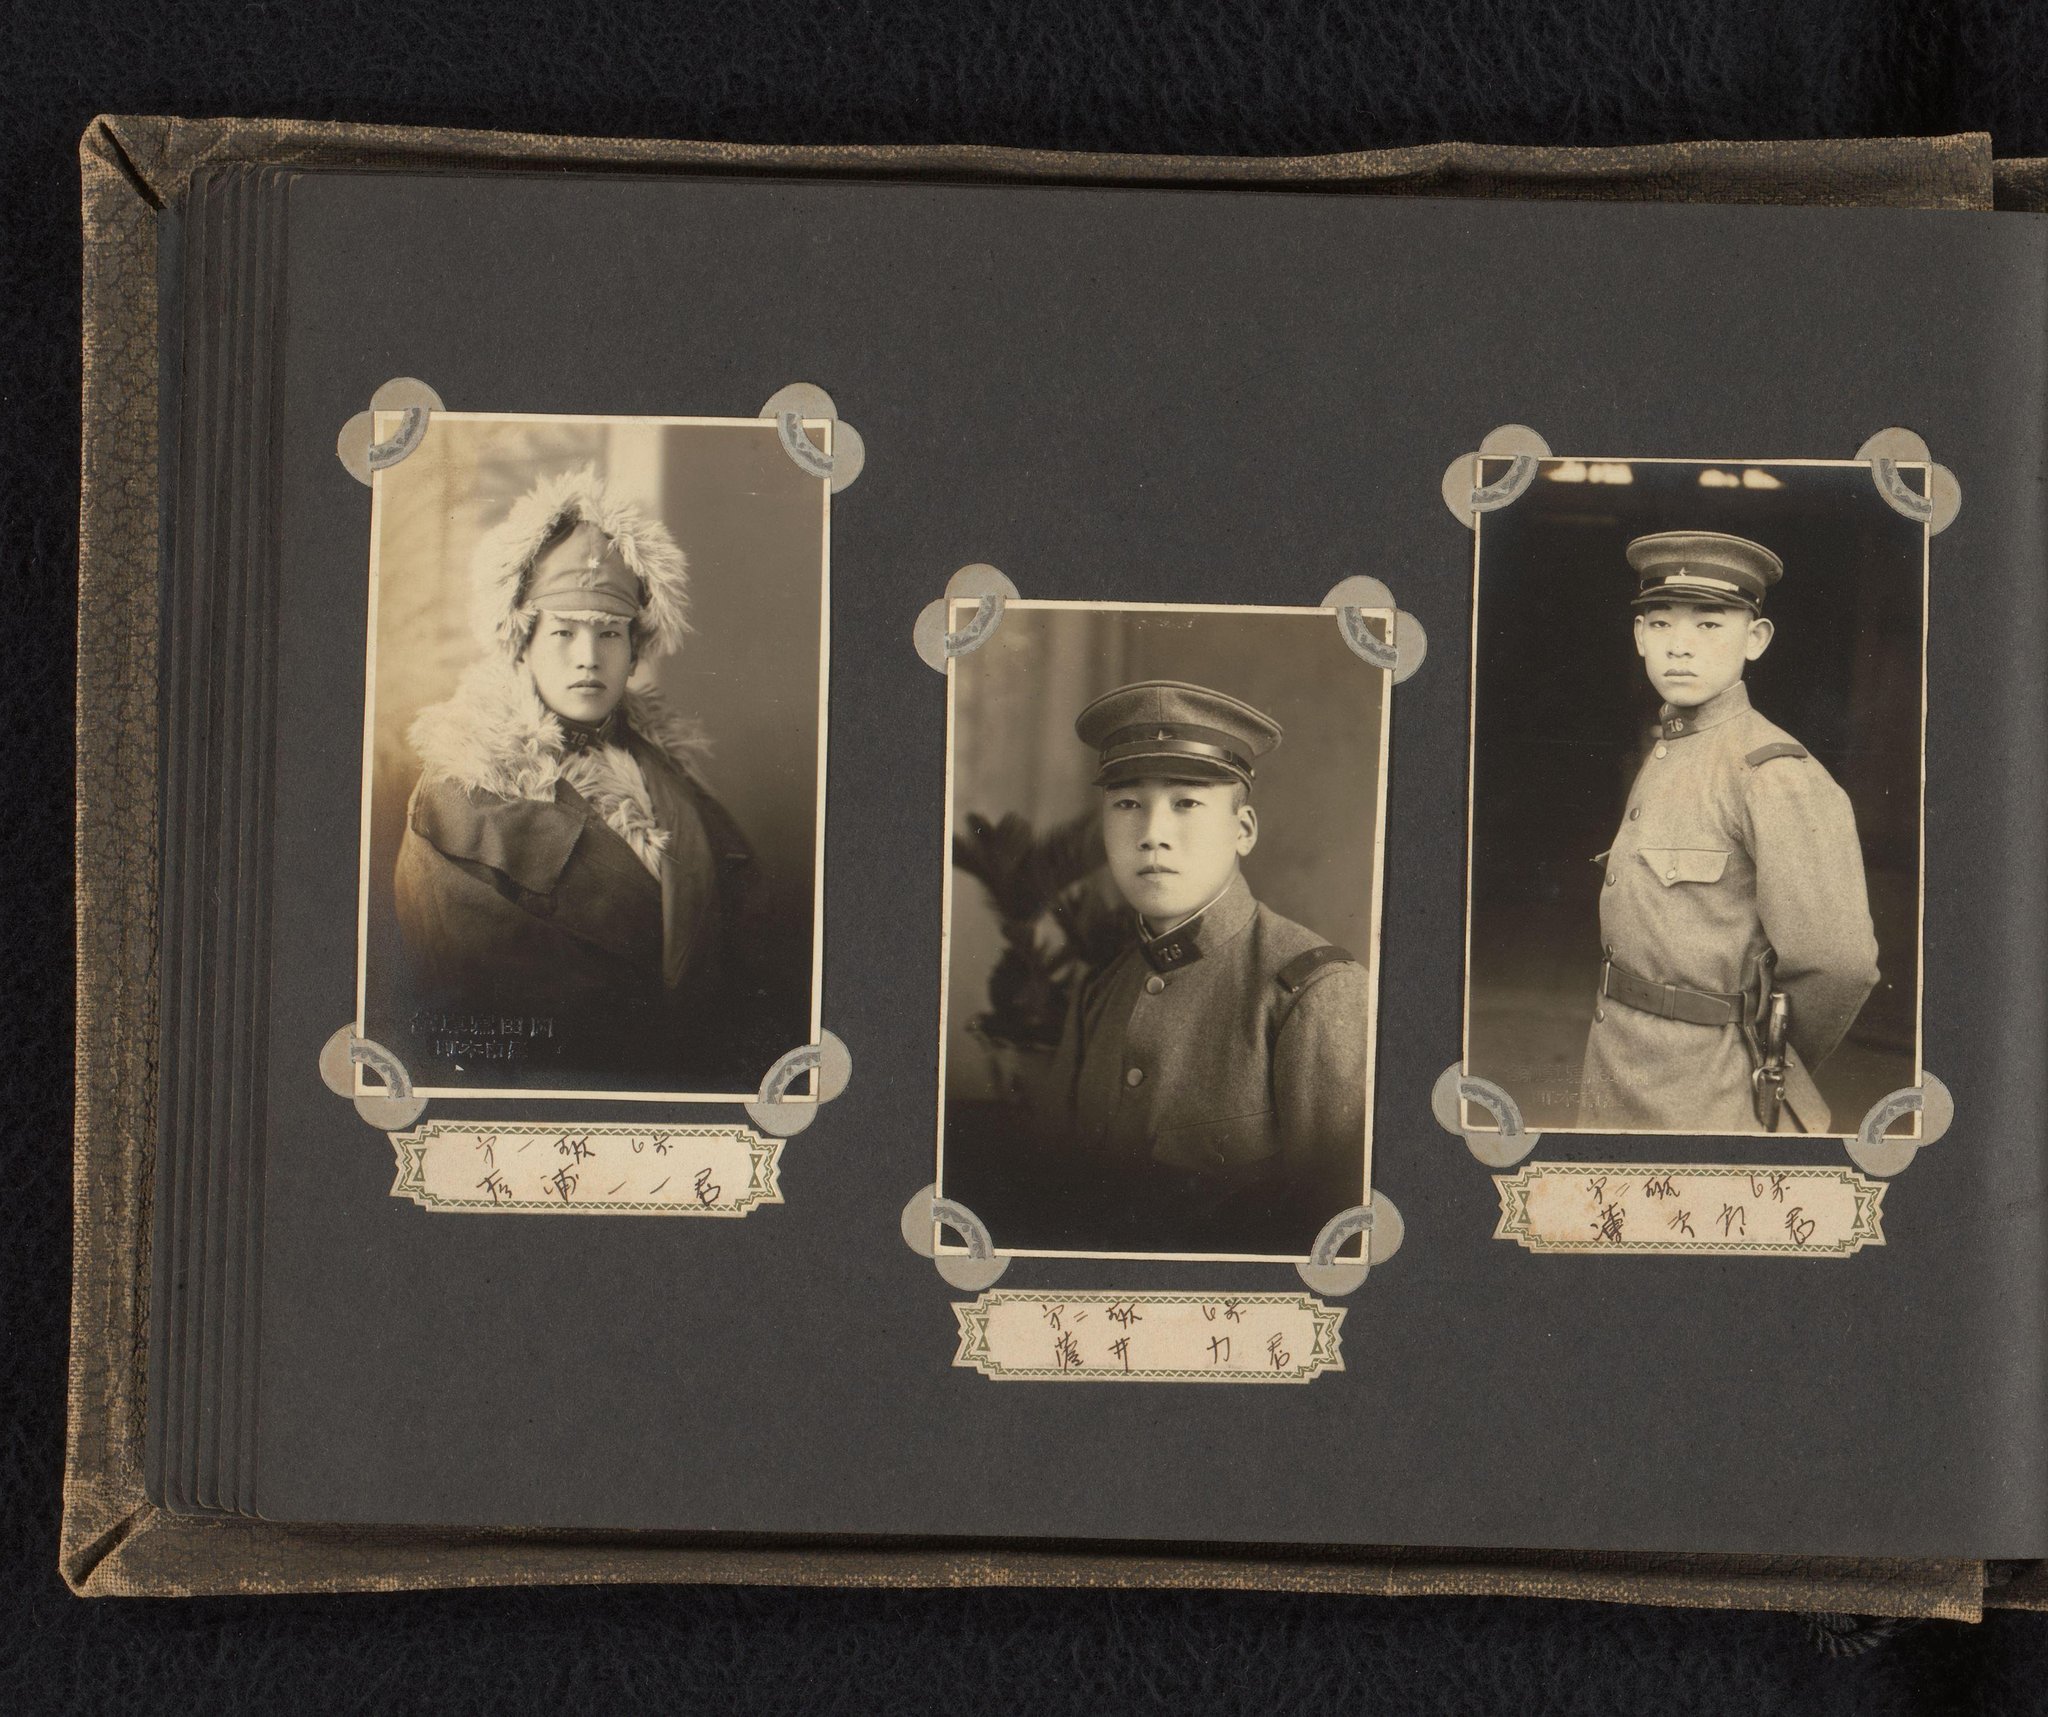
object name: photograph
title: Drie portretten van onbekende Japanse soldaten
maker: Anonymous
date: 1930-1940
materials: paper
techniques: gelatin silver print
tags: anonymous historical person portrayed, the soldier; the soldier's life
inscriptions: inscription: ‘[...]’, inscription: ‘[...]’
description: Deze foto's zijn onderdeel van een album.